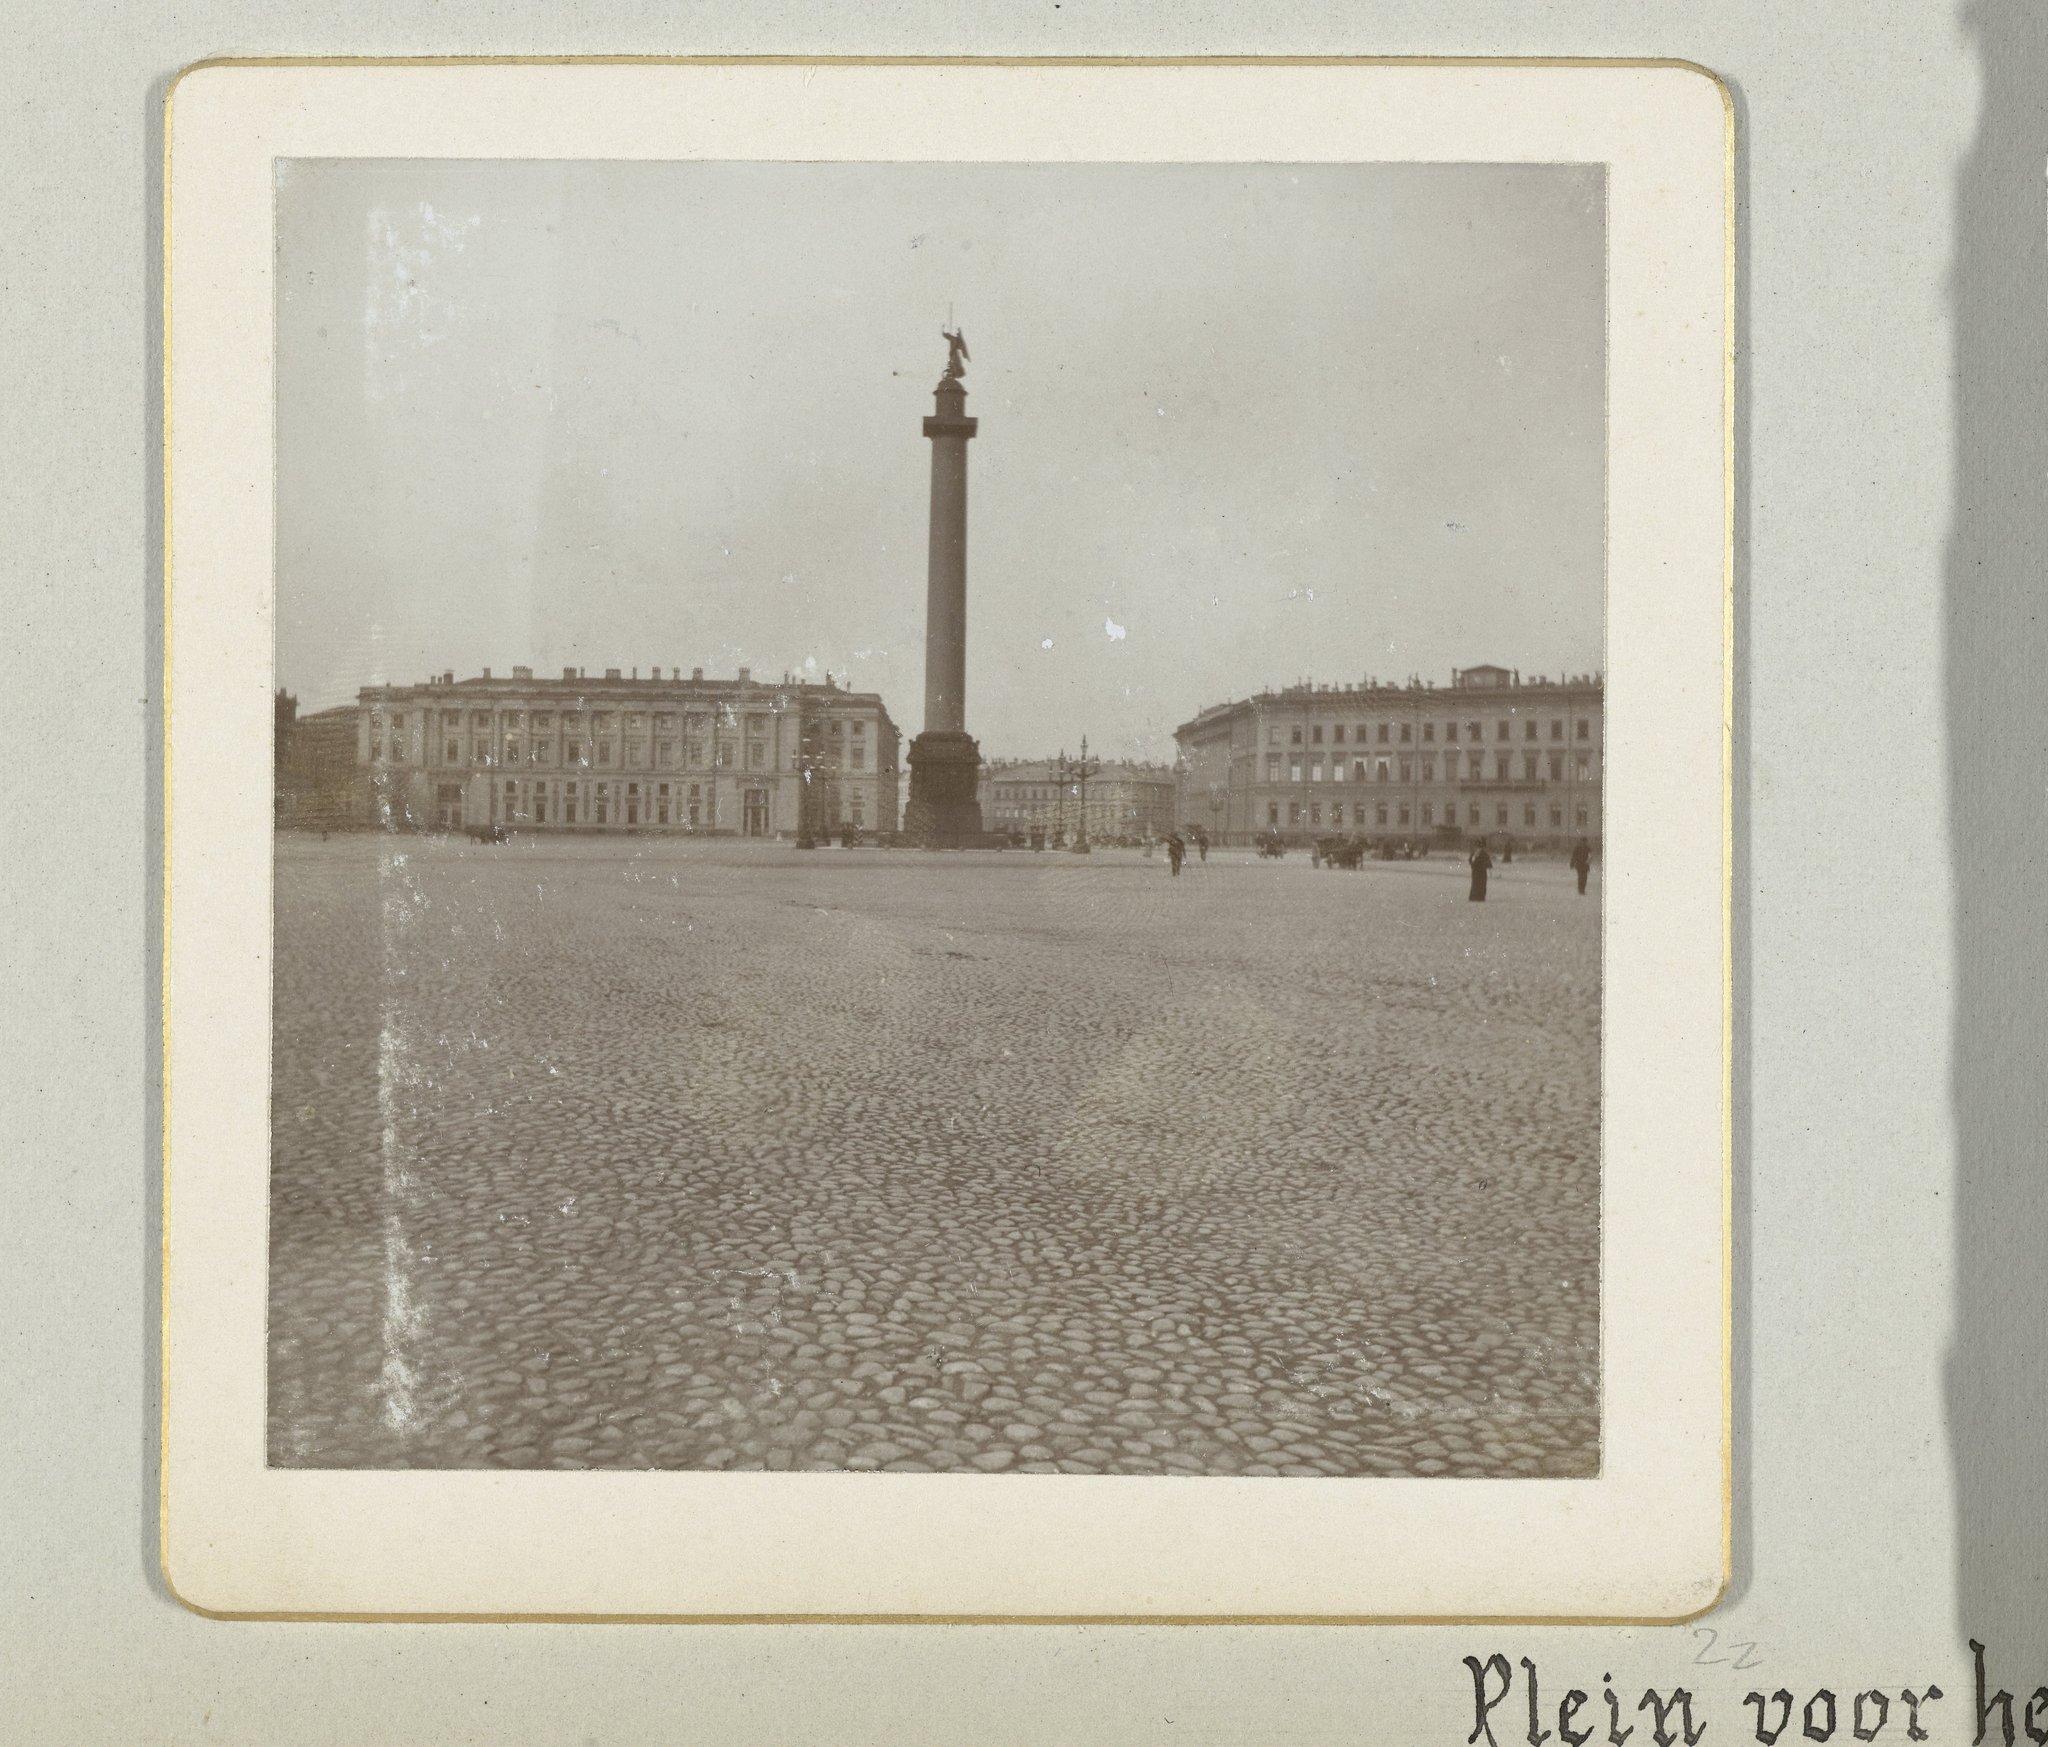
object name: photograph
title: Het plein voor de Hermitage in Sint-Petersburg.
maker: henry pauw van wieldrecht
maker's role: fotograaf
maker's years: 1863-1912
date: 1898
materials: paper, photographic support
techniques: albumen print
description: Het plein voor de Hermitage in Sint-Petersburg. Met op de achtergrond de Hermitage en midden in beeld de Alexander zuil.